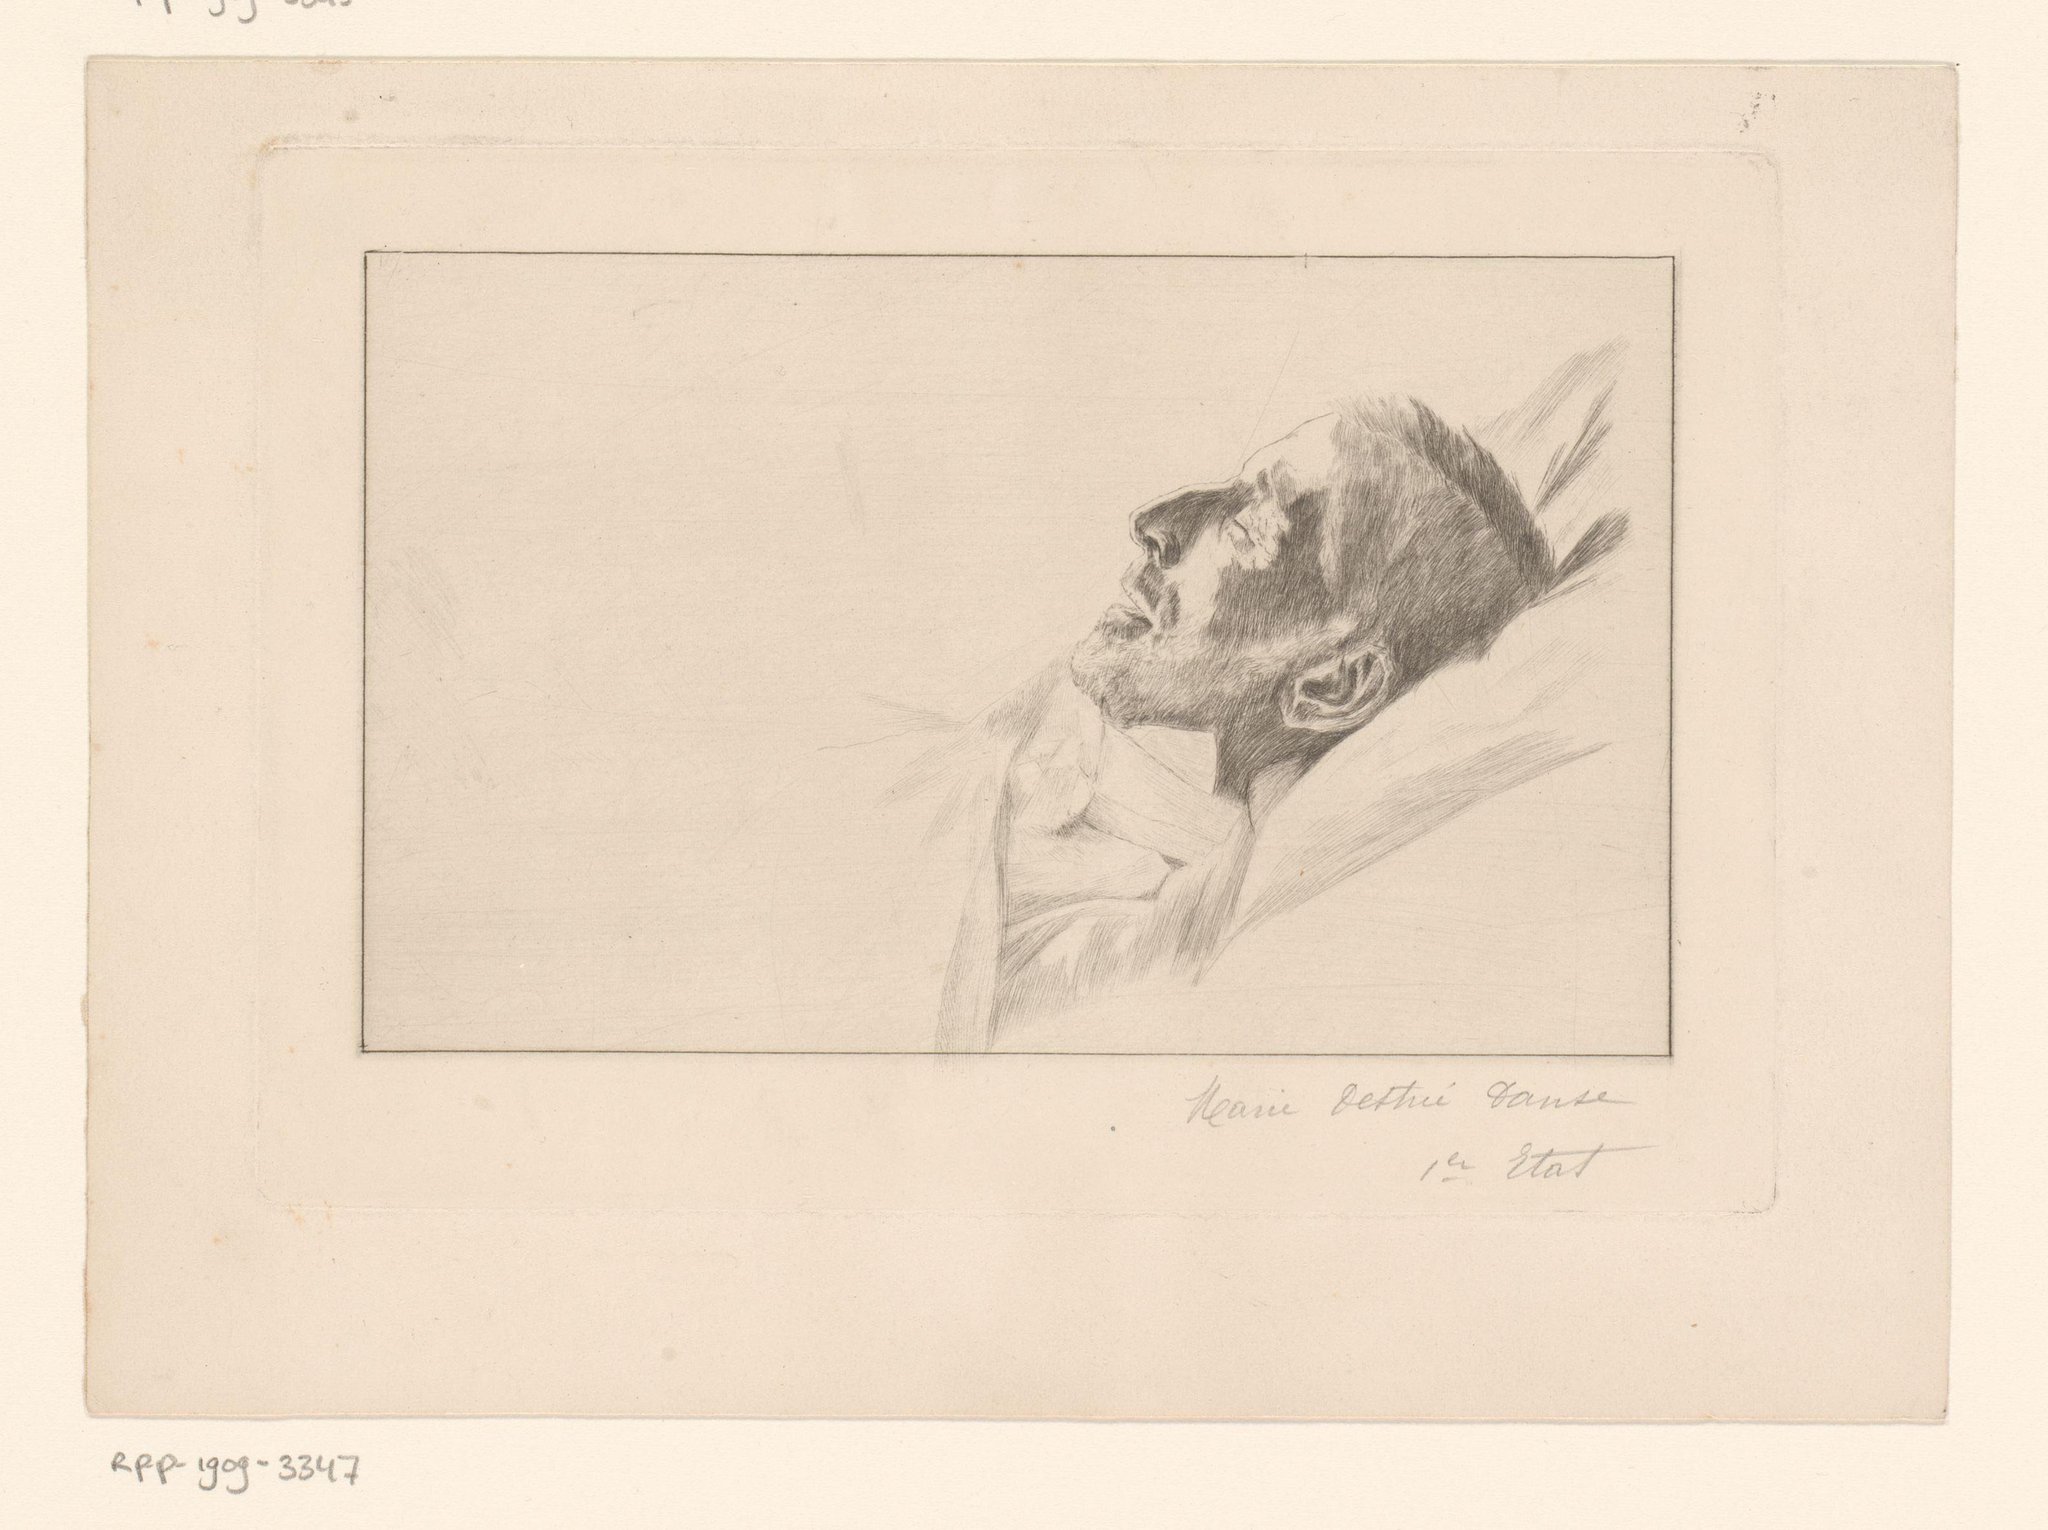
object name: print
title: Portret van een onbekende man op zijn doodsbed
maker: marie danse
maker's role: print maker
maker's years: 1867-1942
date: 1889-1909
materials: paper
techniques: etching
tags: adult man, deathbed, historical persons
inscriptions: inscription: ‘1e Etat’, collector's mark: Lugt 2228